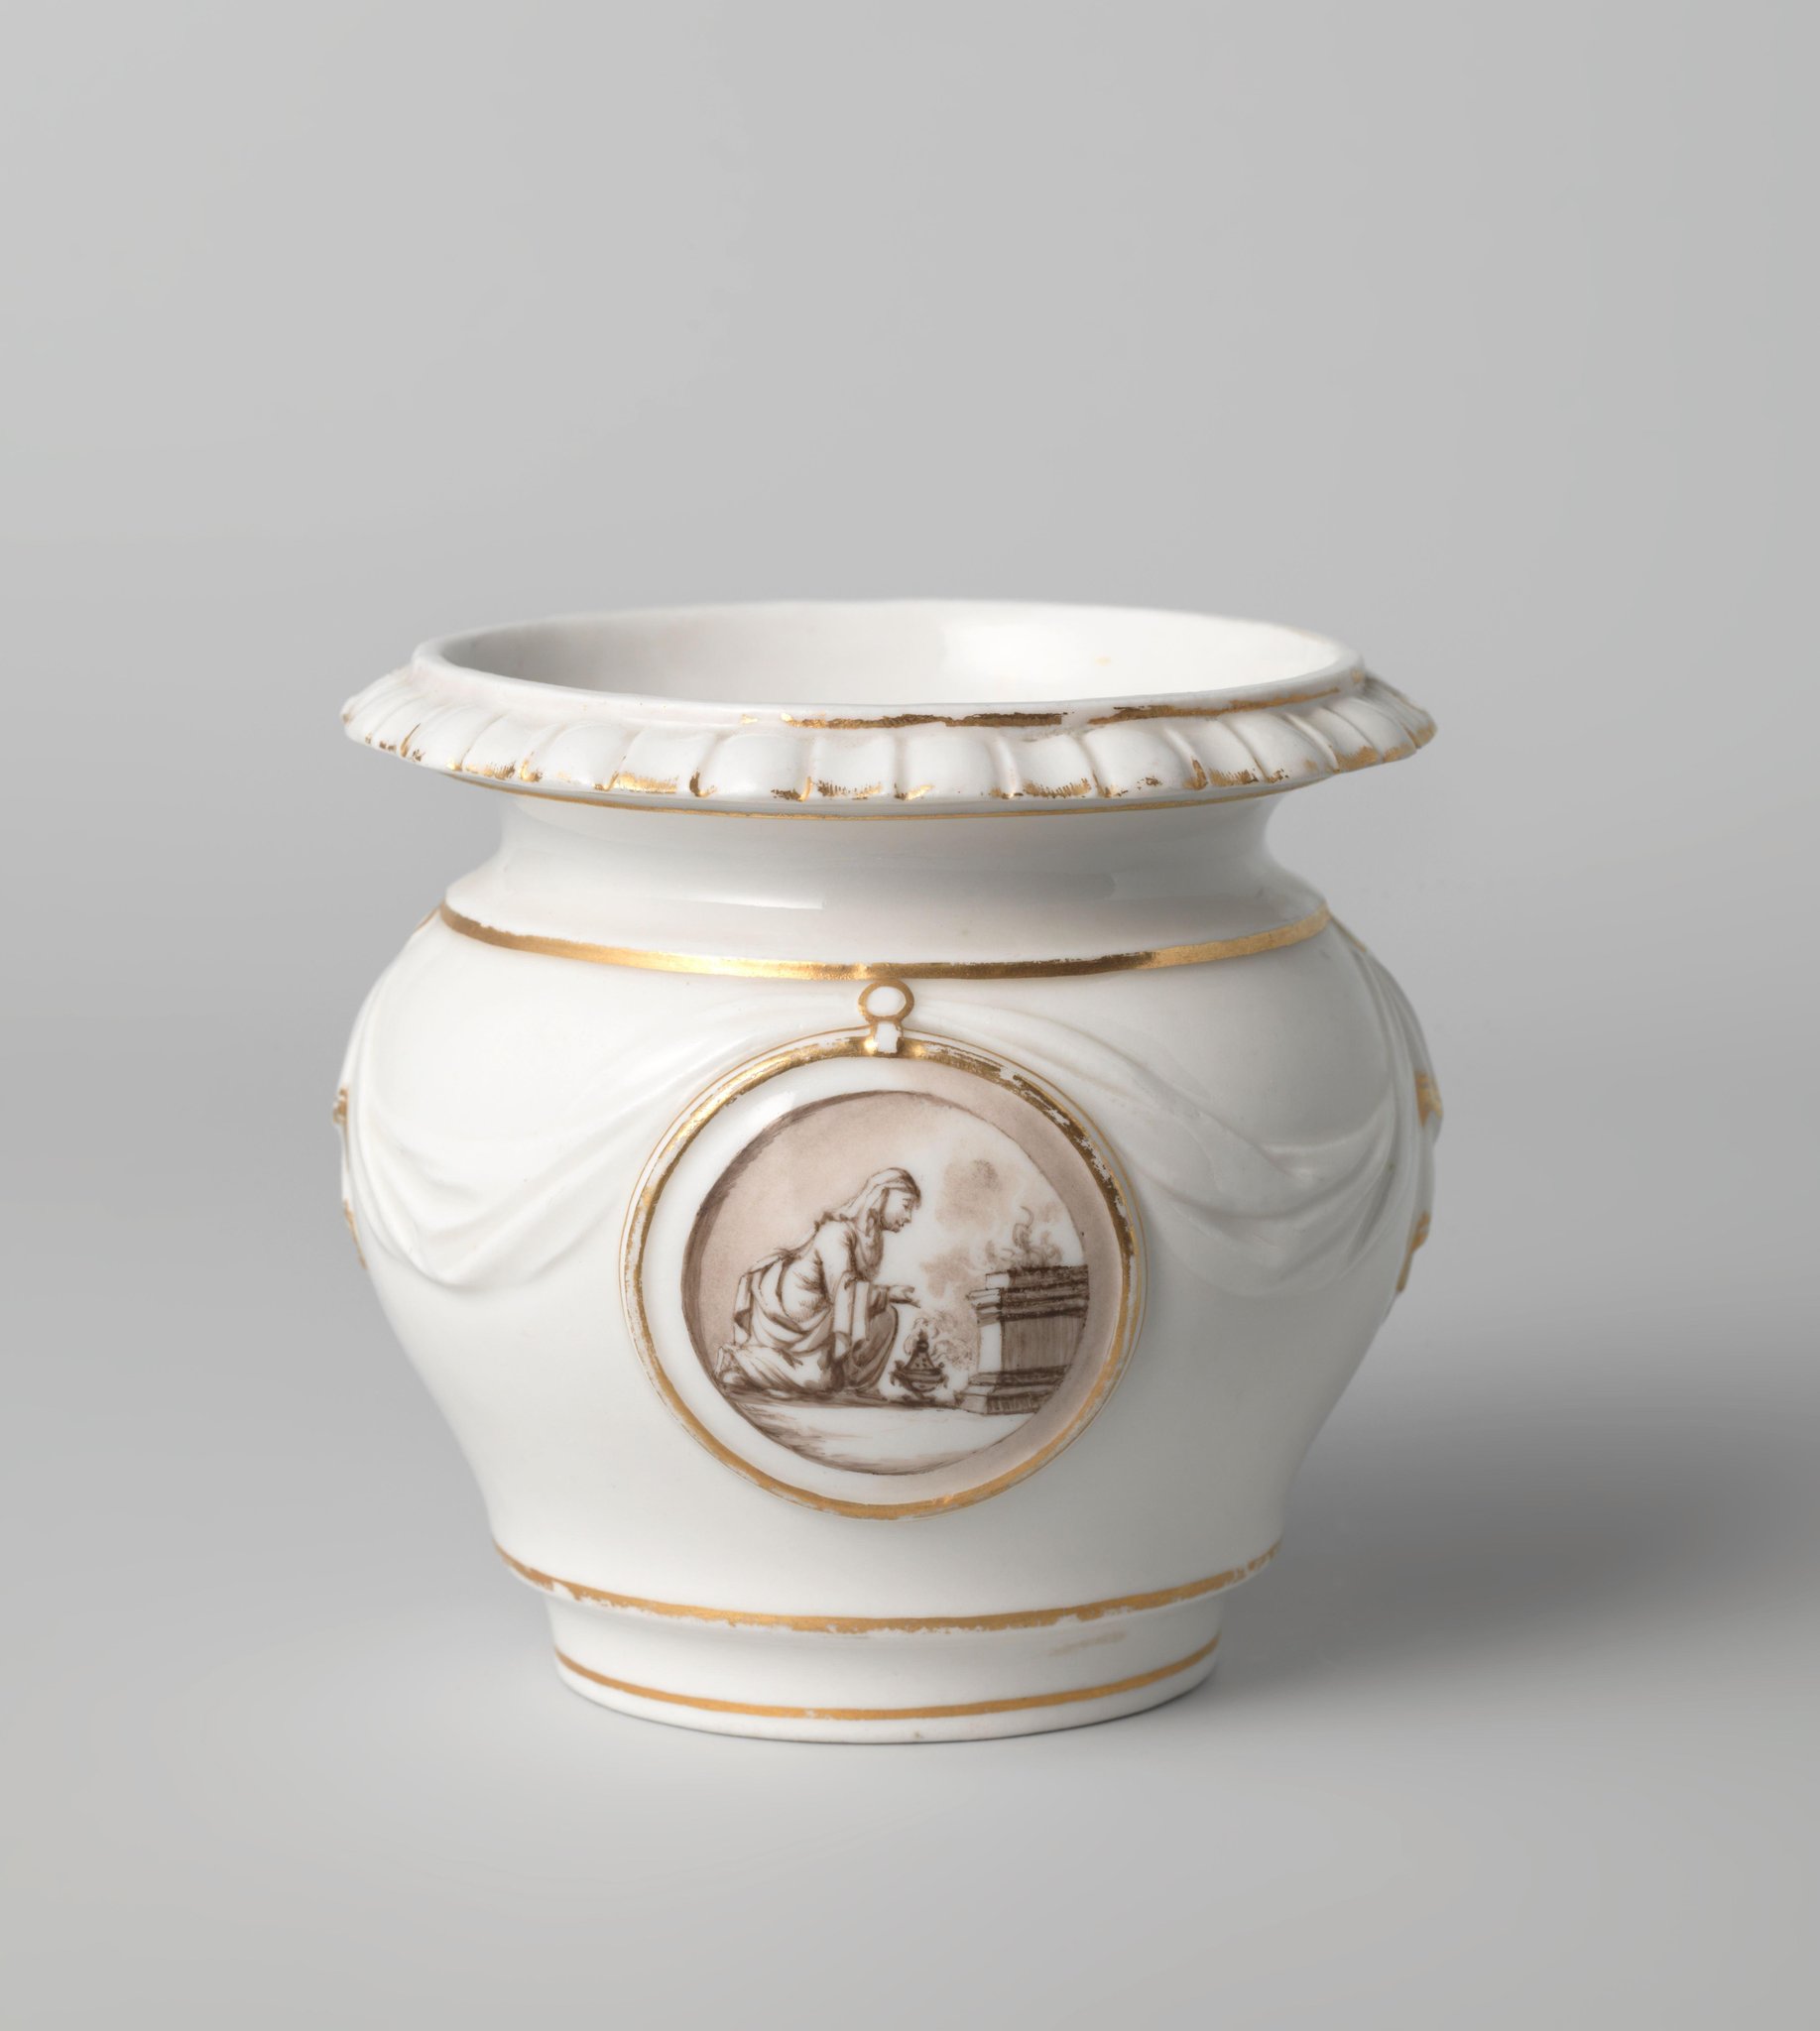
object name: flowerpot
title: Bloempot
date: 1774-1784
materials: porcelain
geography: loosdrecht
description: Bloempot van porselein. Versierd met een draperie in reliëf, en beschilderd met twee ronde medaillons in grisaille. De randen met goud afgezet.